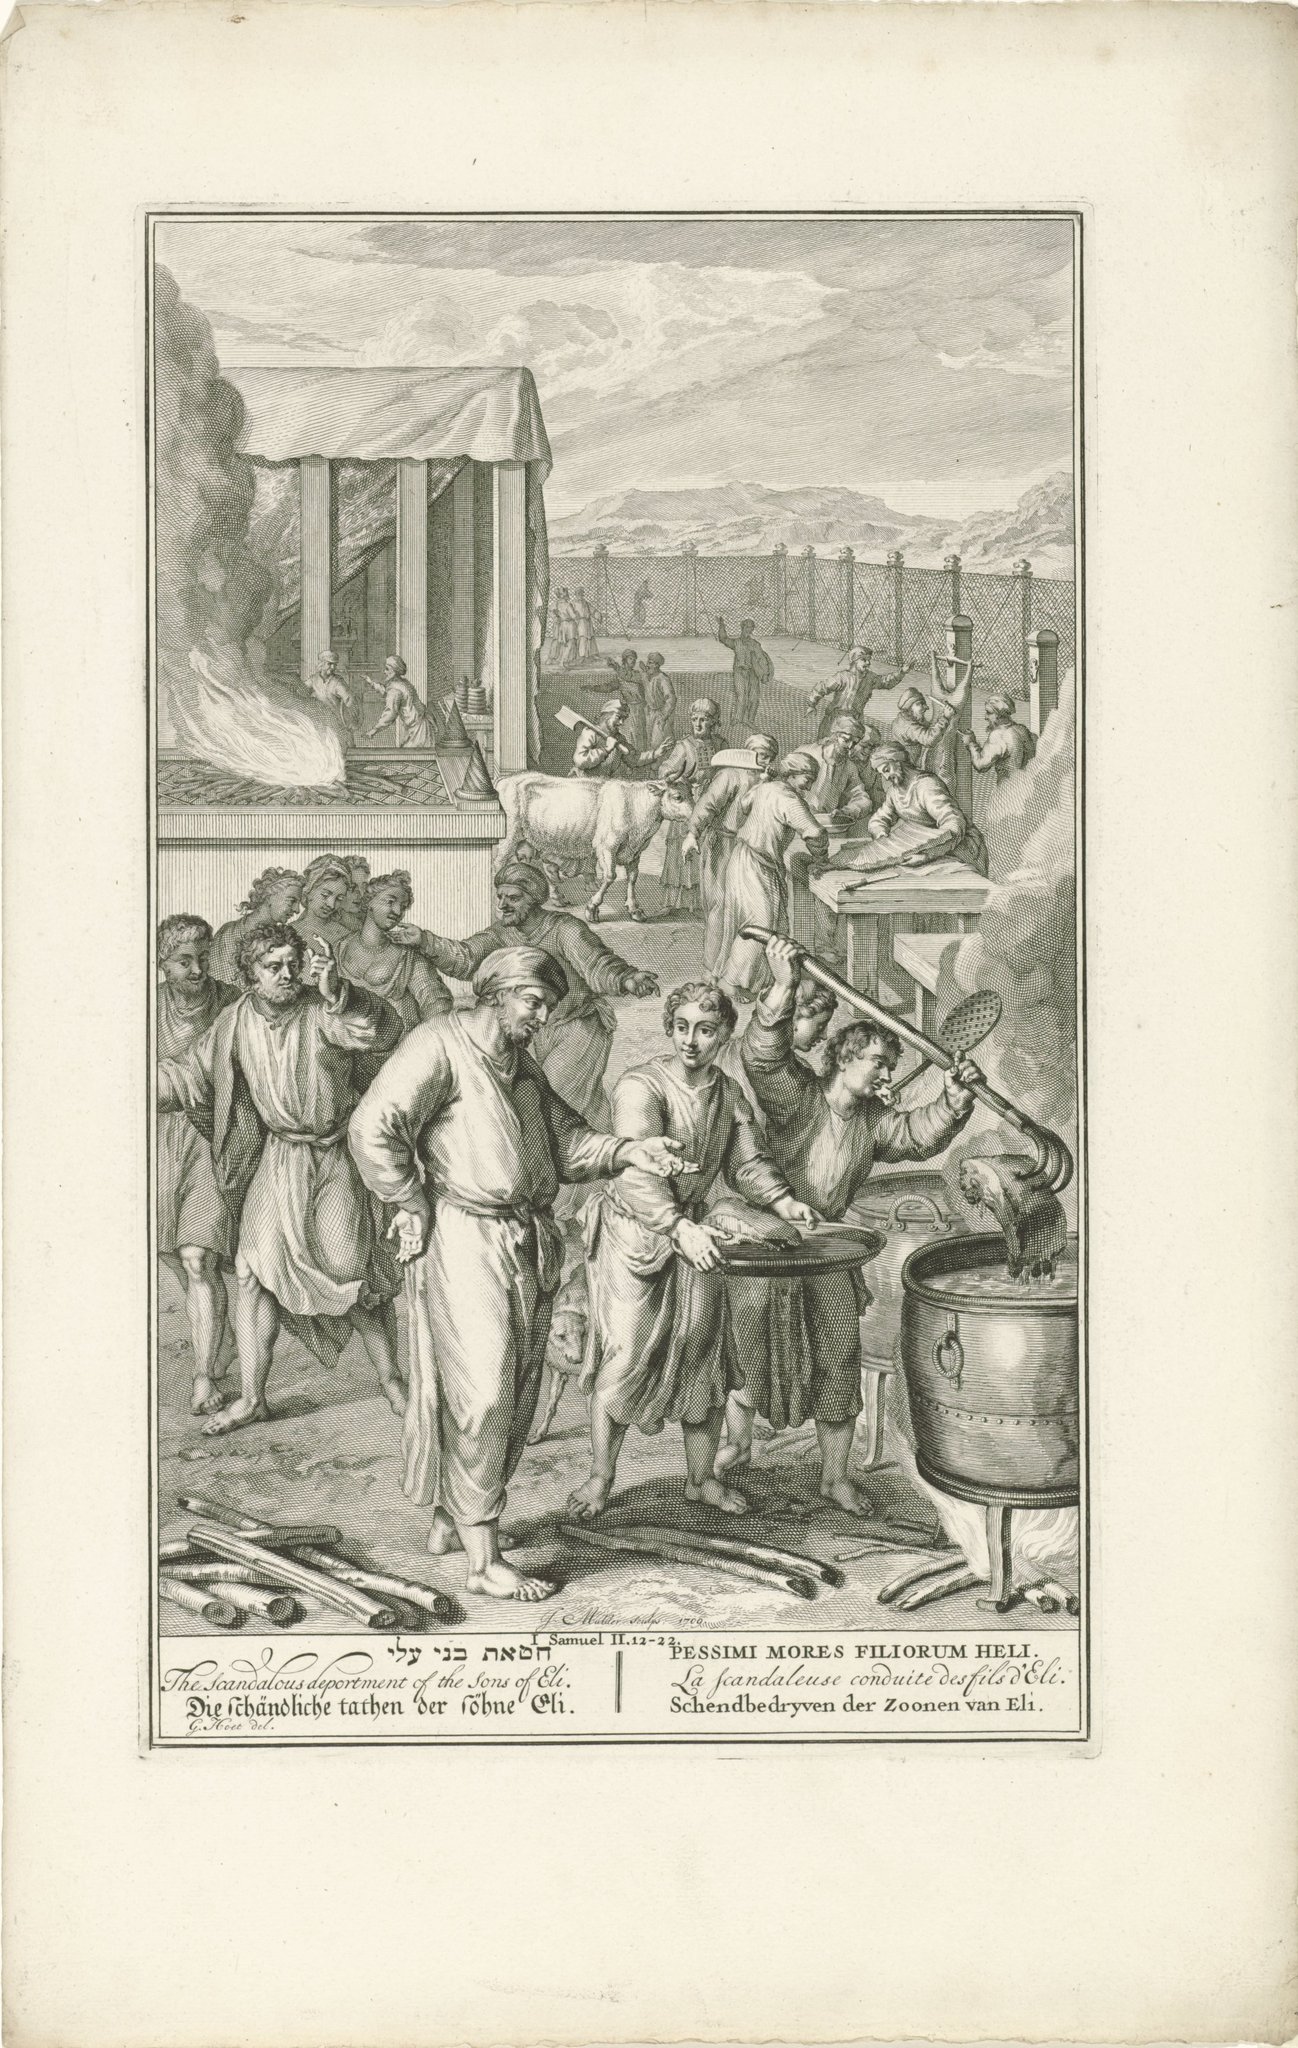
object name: print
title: Wangedrag van de zonen van Eli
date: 1720-1728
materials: paper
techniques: engraving, etching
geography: amsterdam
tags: the sinfulness of eli's sons, hophni and phinehas (1 samuel 2:12-17)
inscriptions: collector's mark: Lugt 2228, inscription: ‘Utrechts Fundatie huijs’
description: De zonen van Eli, die als priesters in de tempel dienst doen, misdragen zich. Het vlees dat de Israëlieten brengen om aan God te offeren, wordt door de zonen van Eli in beslag genomen om het zelf op te eten. Op de achtergrond het altaar en de tempel. Op de voorgrond geeft een zoon van Eli opdracht vlees uit een pan te halen. Een andere zoon zit achter de vrouwen aan. Onderaan in de marge een verwijzing naar de Bijbeltekst en de titel in het Hebreeuws, Engels, Duits, Latijn, Frans en Nederlands.